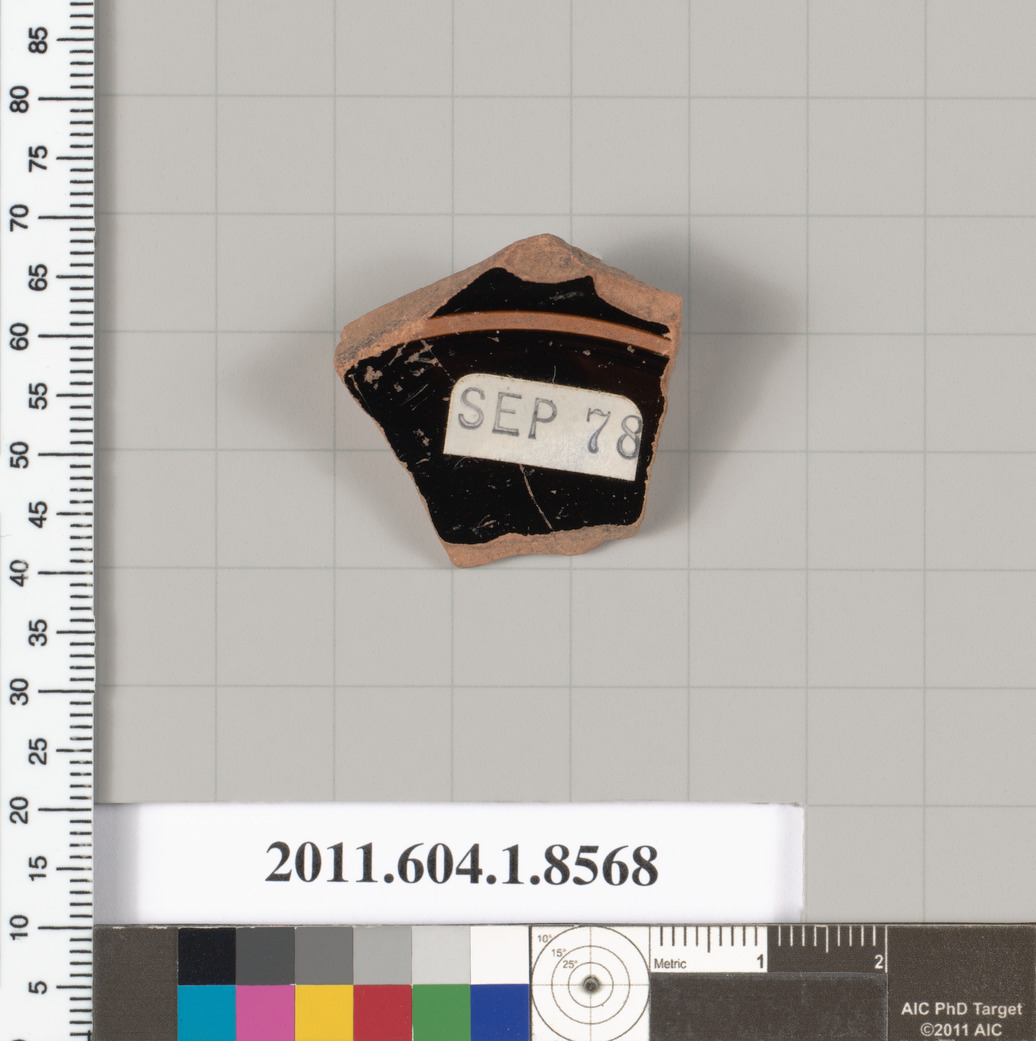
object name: kylix fragment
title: Terracotta fragment of a stemless kylix (drinking cup)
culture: greek, attic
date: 470-450 BCE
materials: terracotta